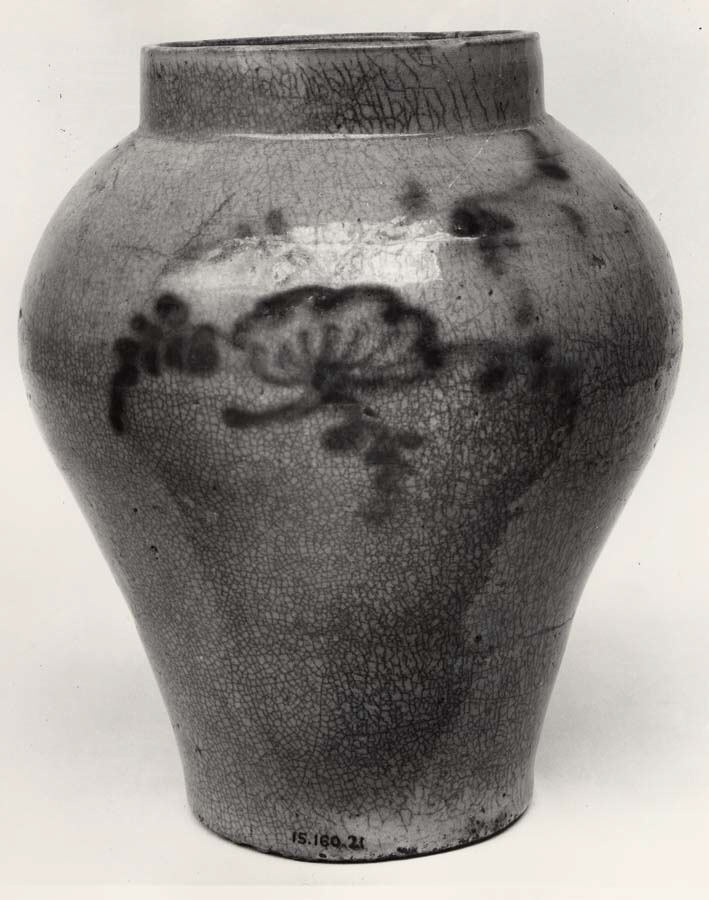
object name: jar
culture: korean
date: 1801-1900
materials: copper, porcelain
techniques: underglaze